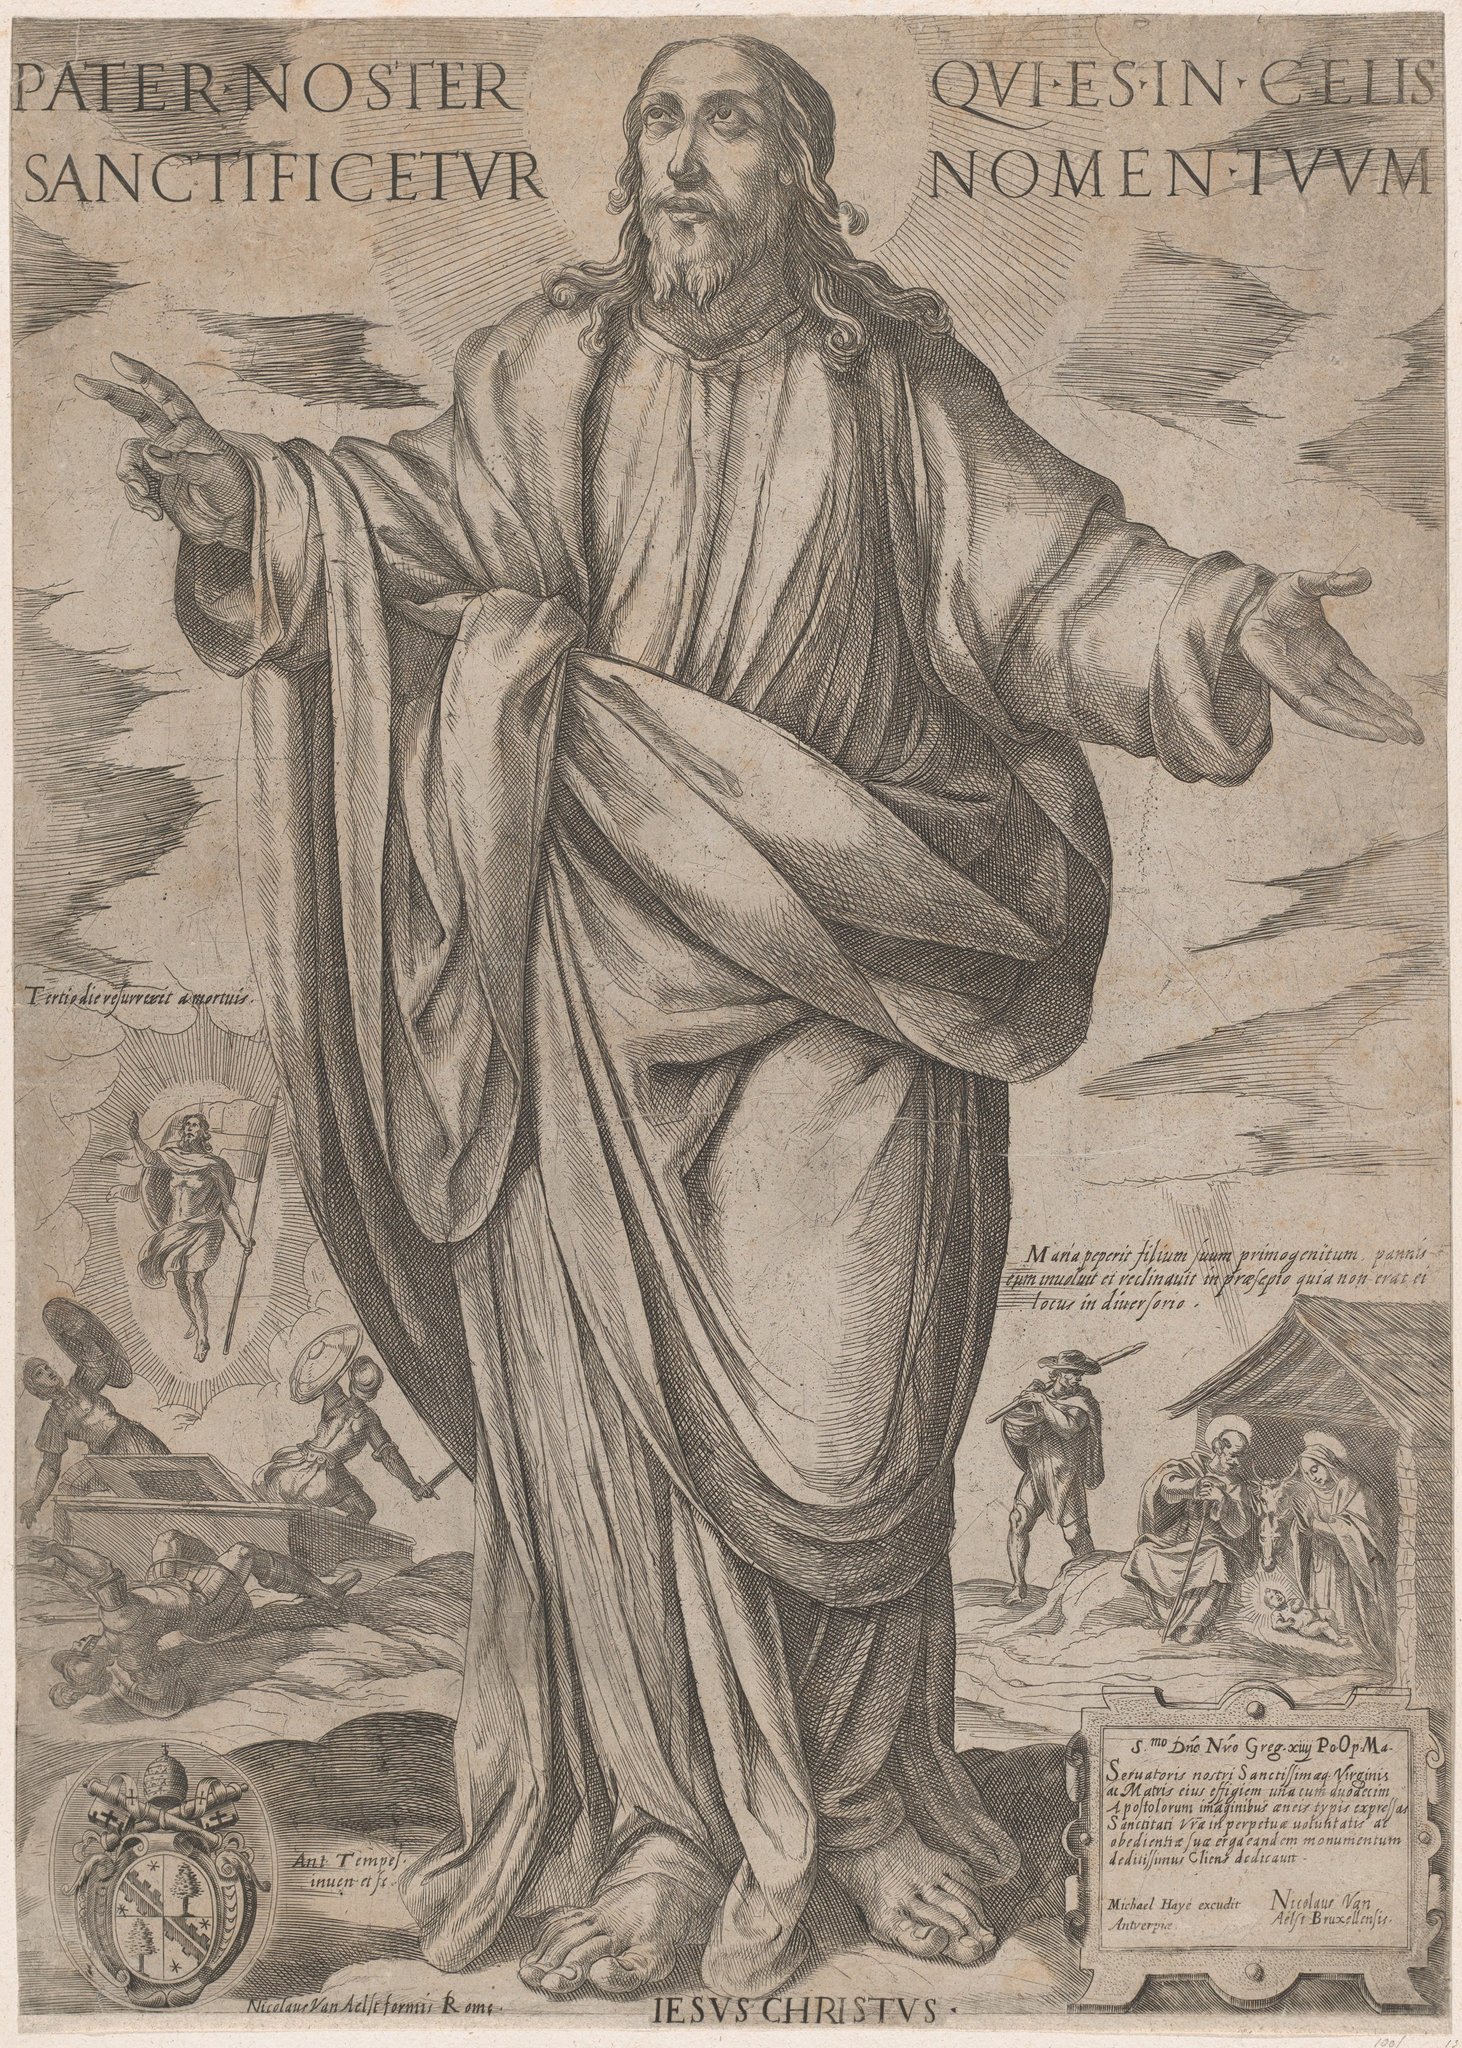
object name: print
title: Standing Christ, Blessing from "Christ, Mary and the Apostles"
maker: antonio tempesta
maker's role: artist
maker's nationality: italian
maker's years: 1555-1630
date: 1590-1610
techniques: etching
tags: christ